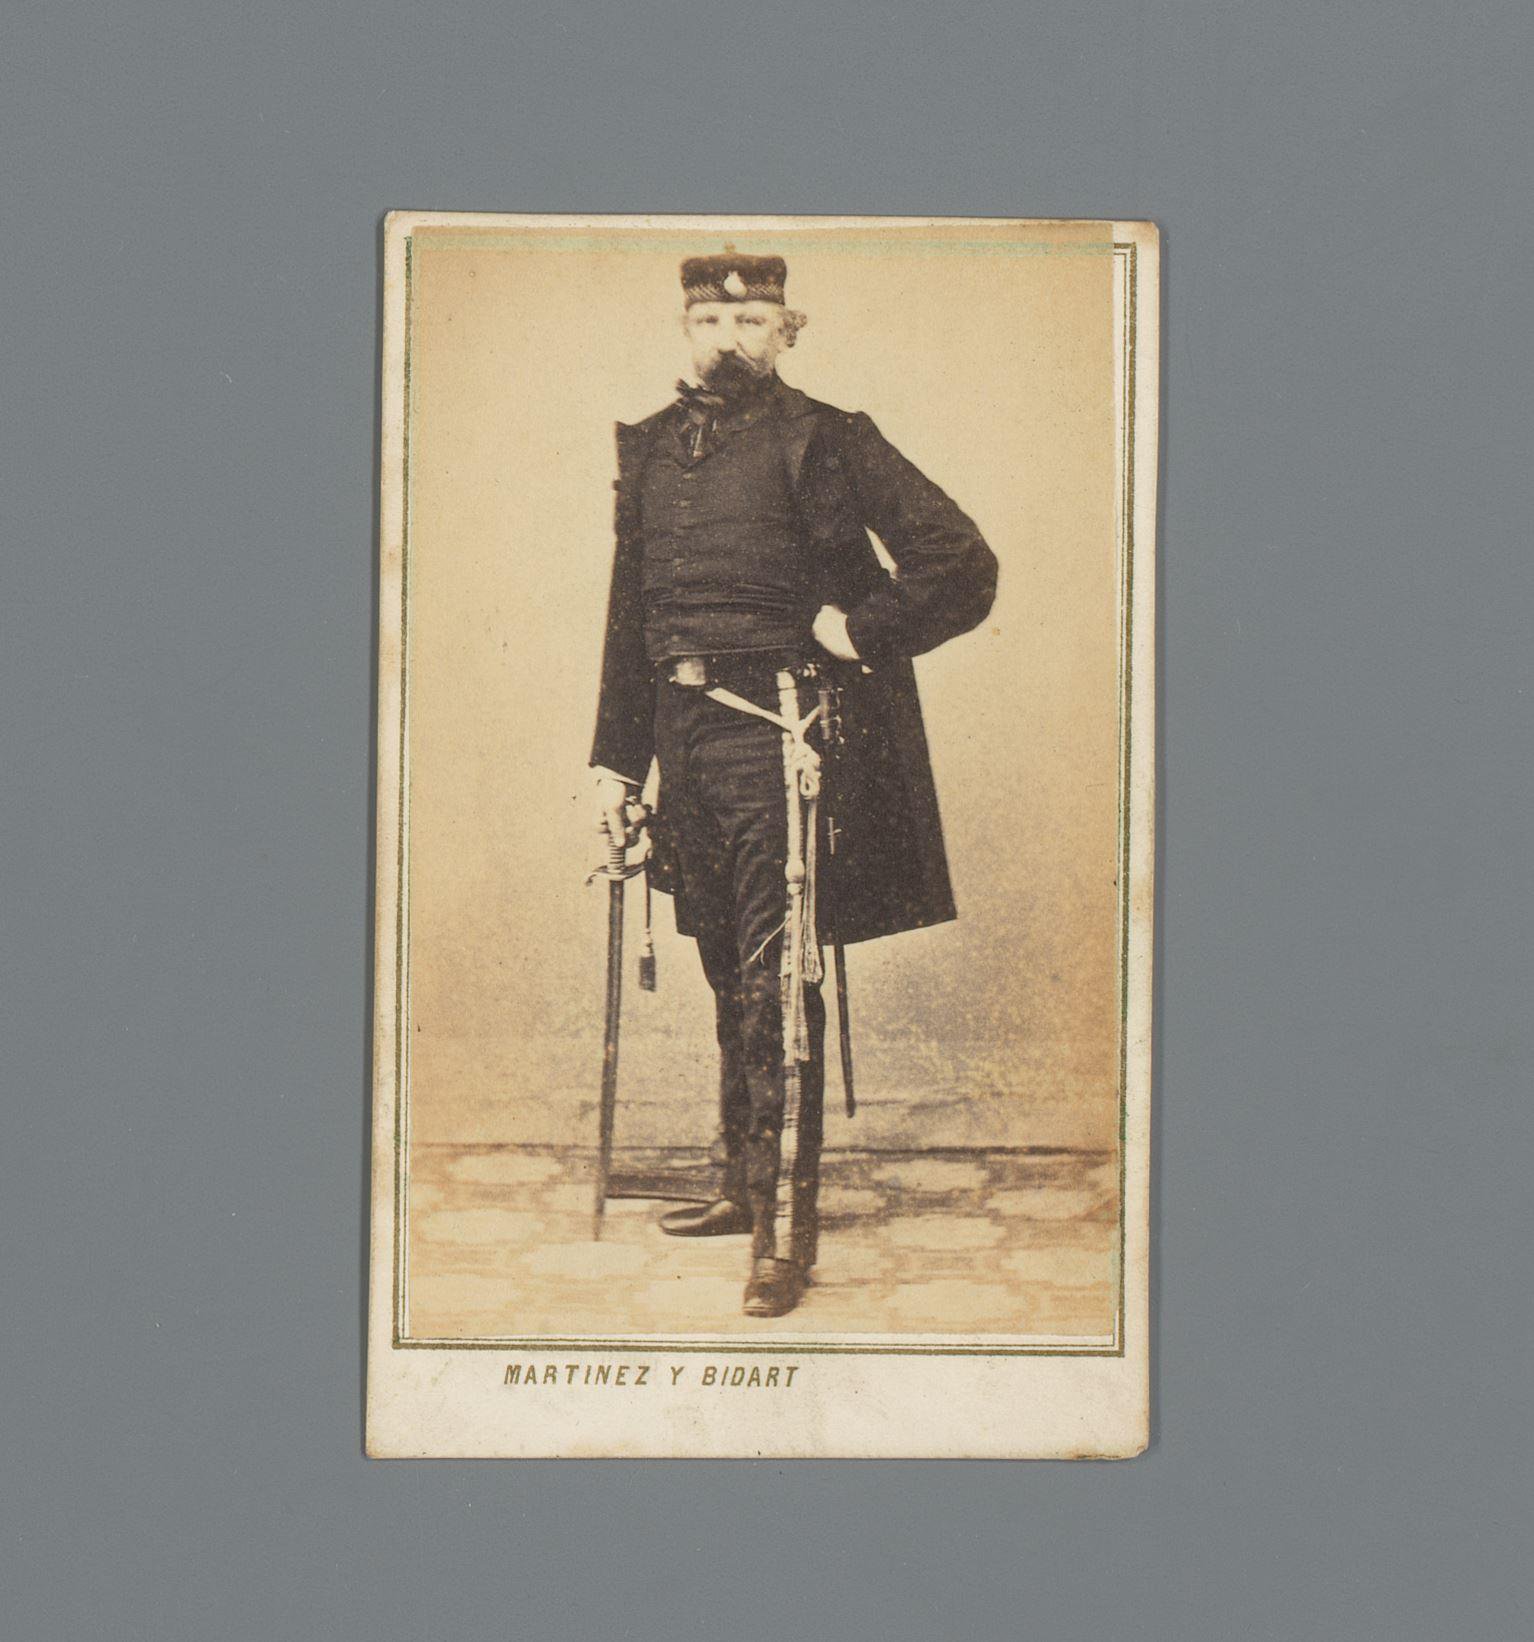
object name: carte de visite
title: Portret van een onbekende man in militair uniform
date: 1860-1885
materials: cardboard, paper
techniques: albumen print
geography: montevideo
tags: adult man, anonymous historical person portrayed, (military) uniforms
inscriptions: inscription: ‘Martinez y Bidart’, inscription: ‘Fotografia de la Paz/ Martinez y Bidart/ Fotógrafos/ 221, Calle 25 de Mayo, 221./ Montevideo’